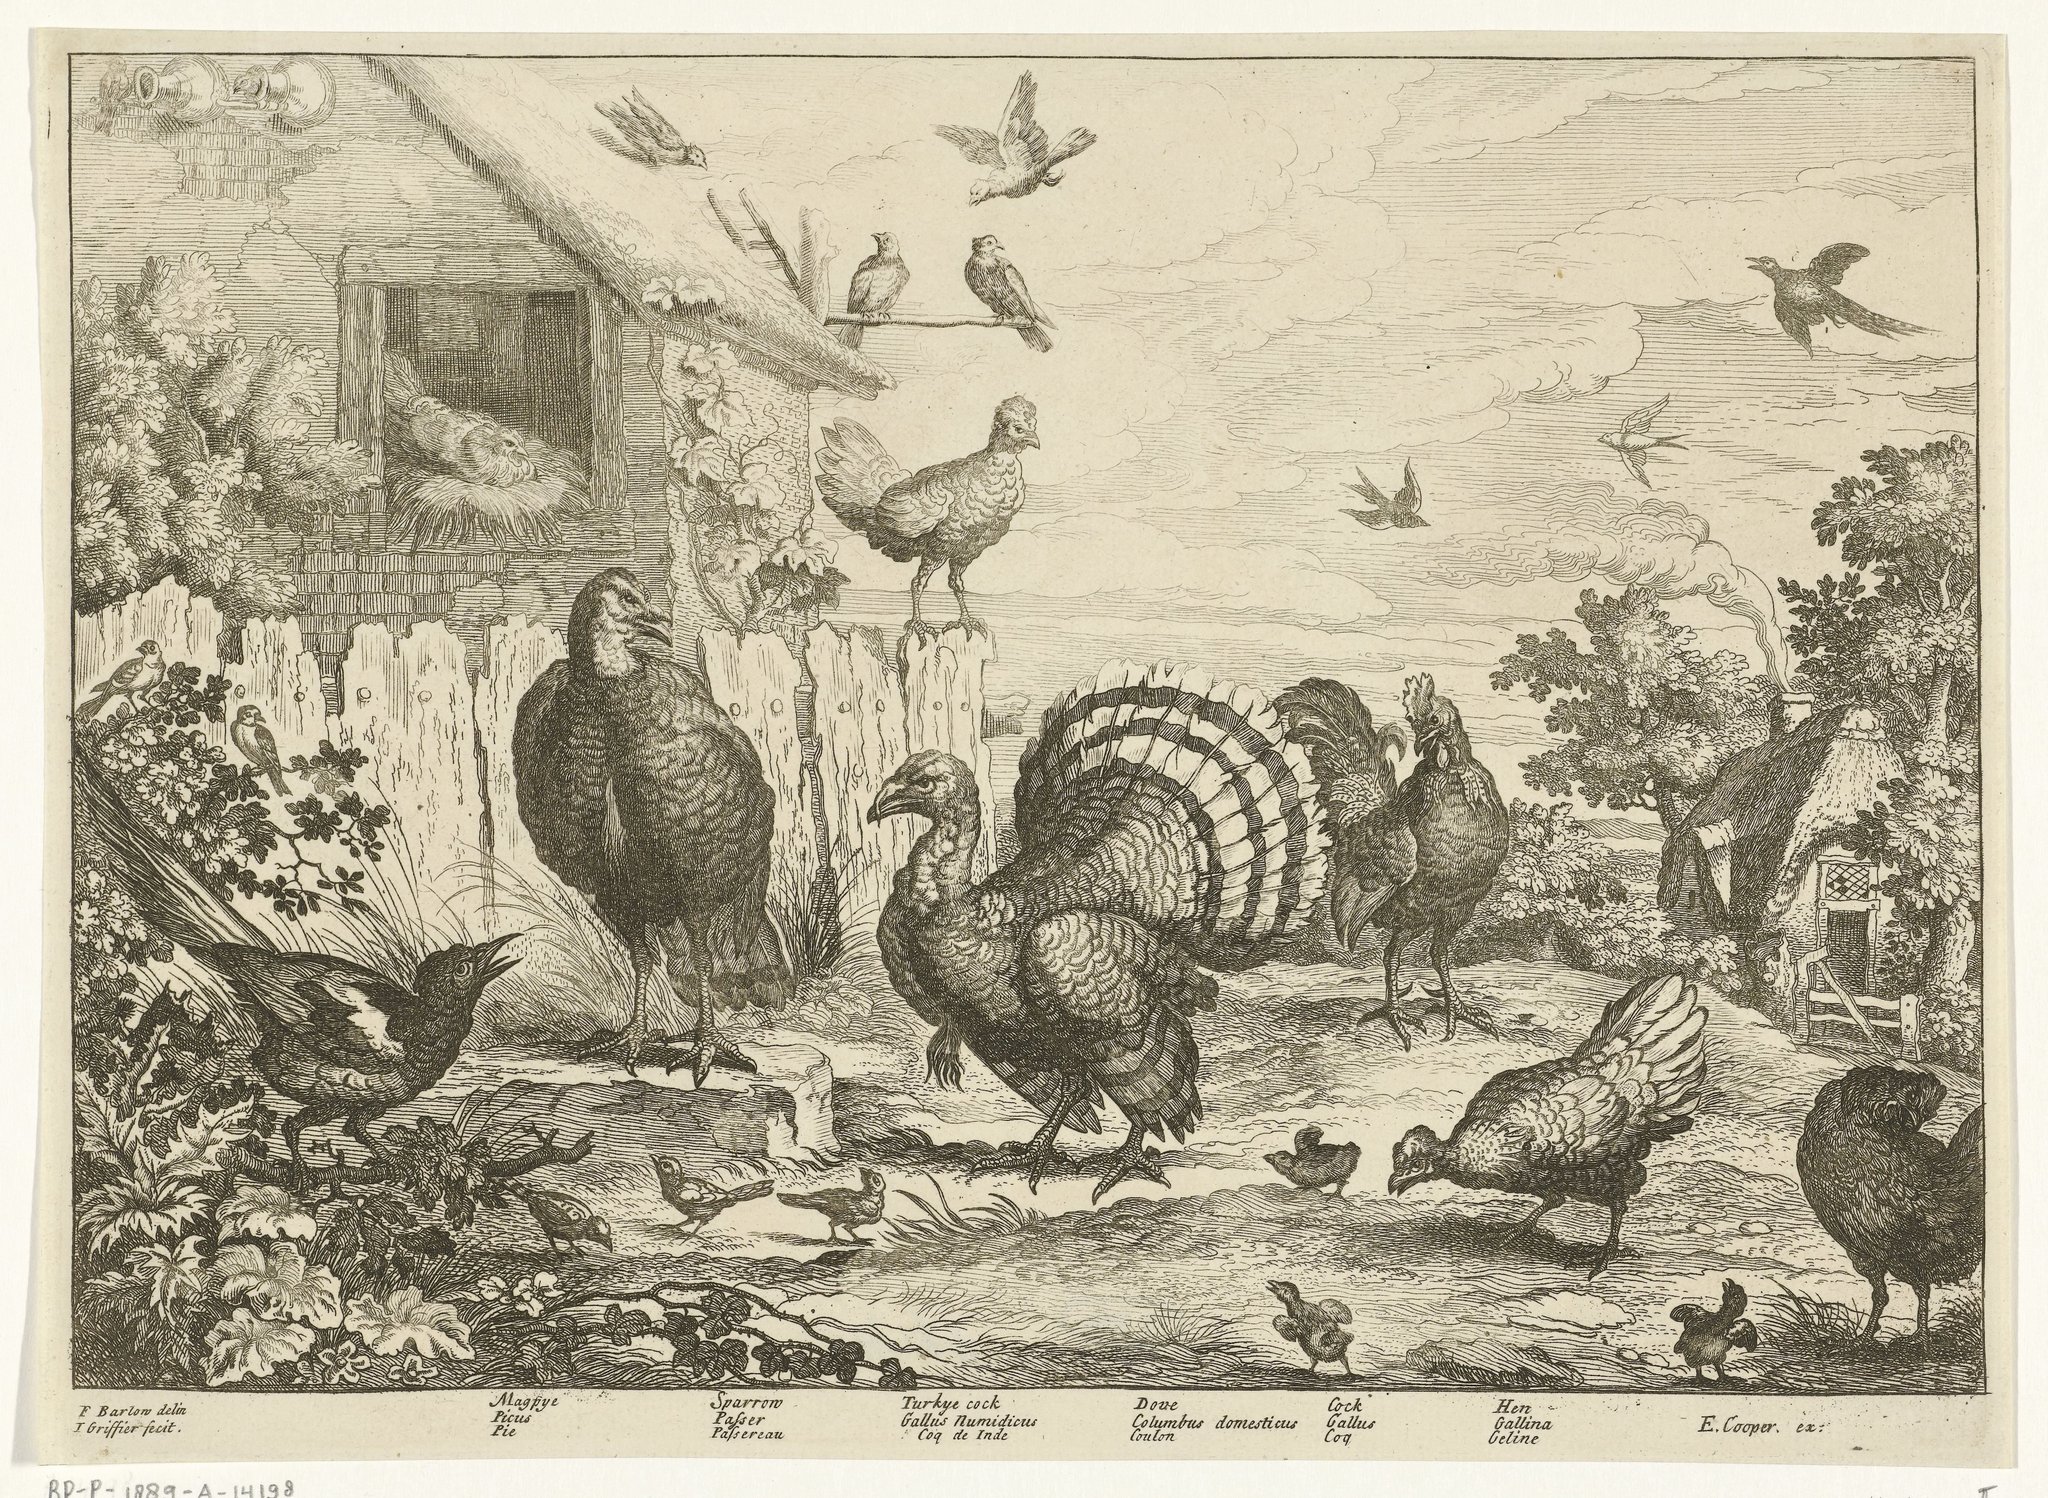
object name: print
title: Pluimvee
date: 1655-1718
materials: paper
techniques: engraving, etching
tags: birds, walker and runner birds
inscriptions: collector's mark: Lugt 2228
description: Pluimvee bij een boerenhuis en een duiventil. Op de voorgrond een kalkoen, een aantal kippen, een haan en ander gevogelte. In het marge de namen van de vogels in het Engels, Latijn en Frans.